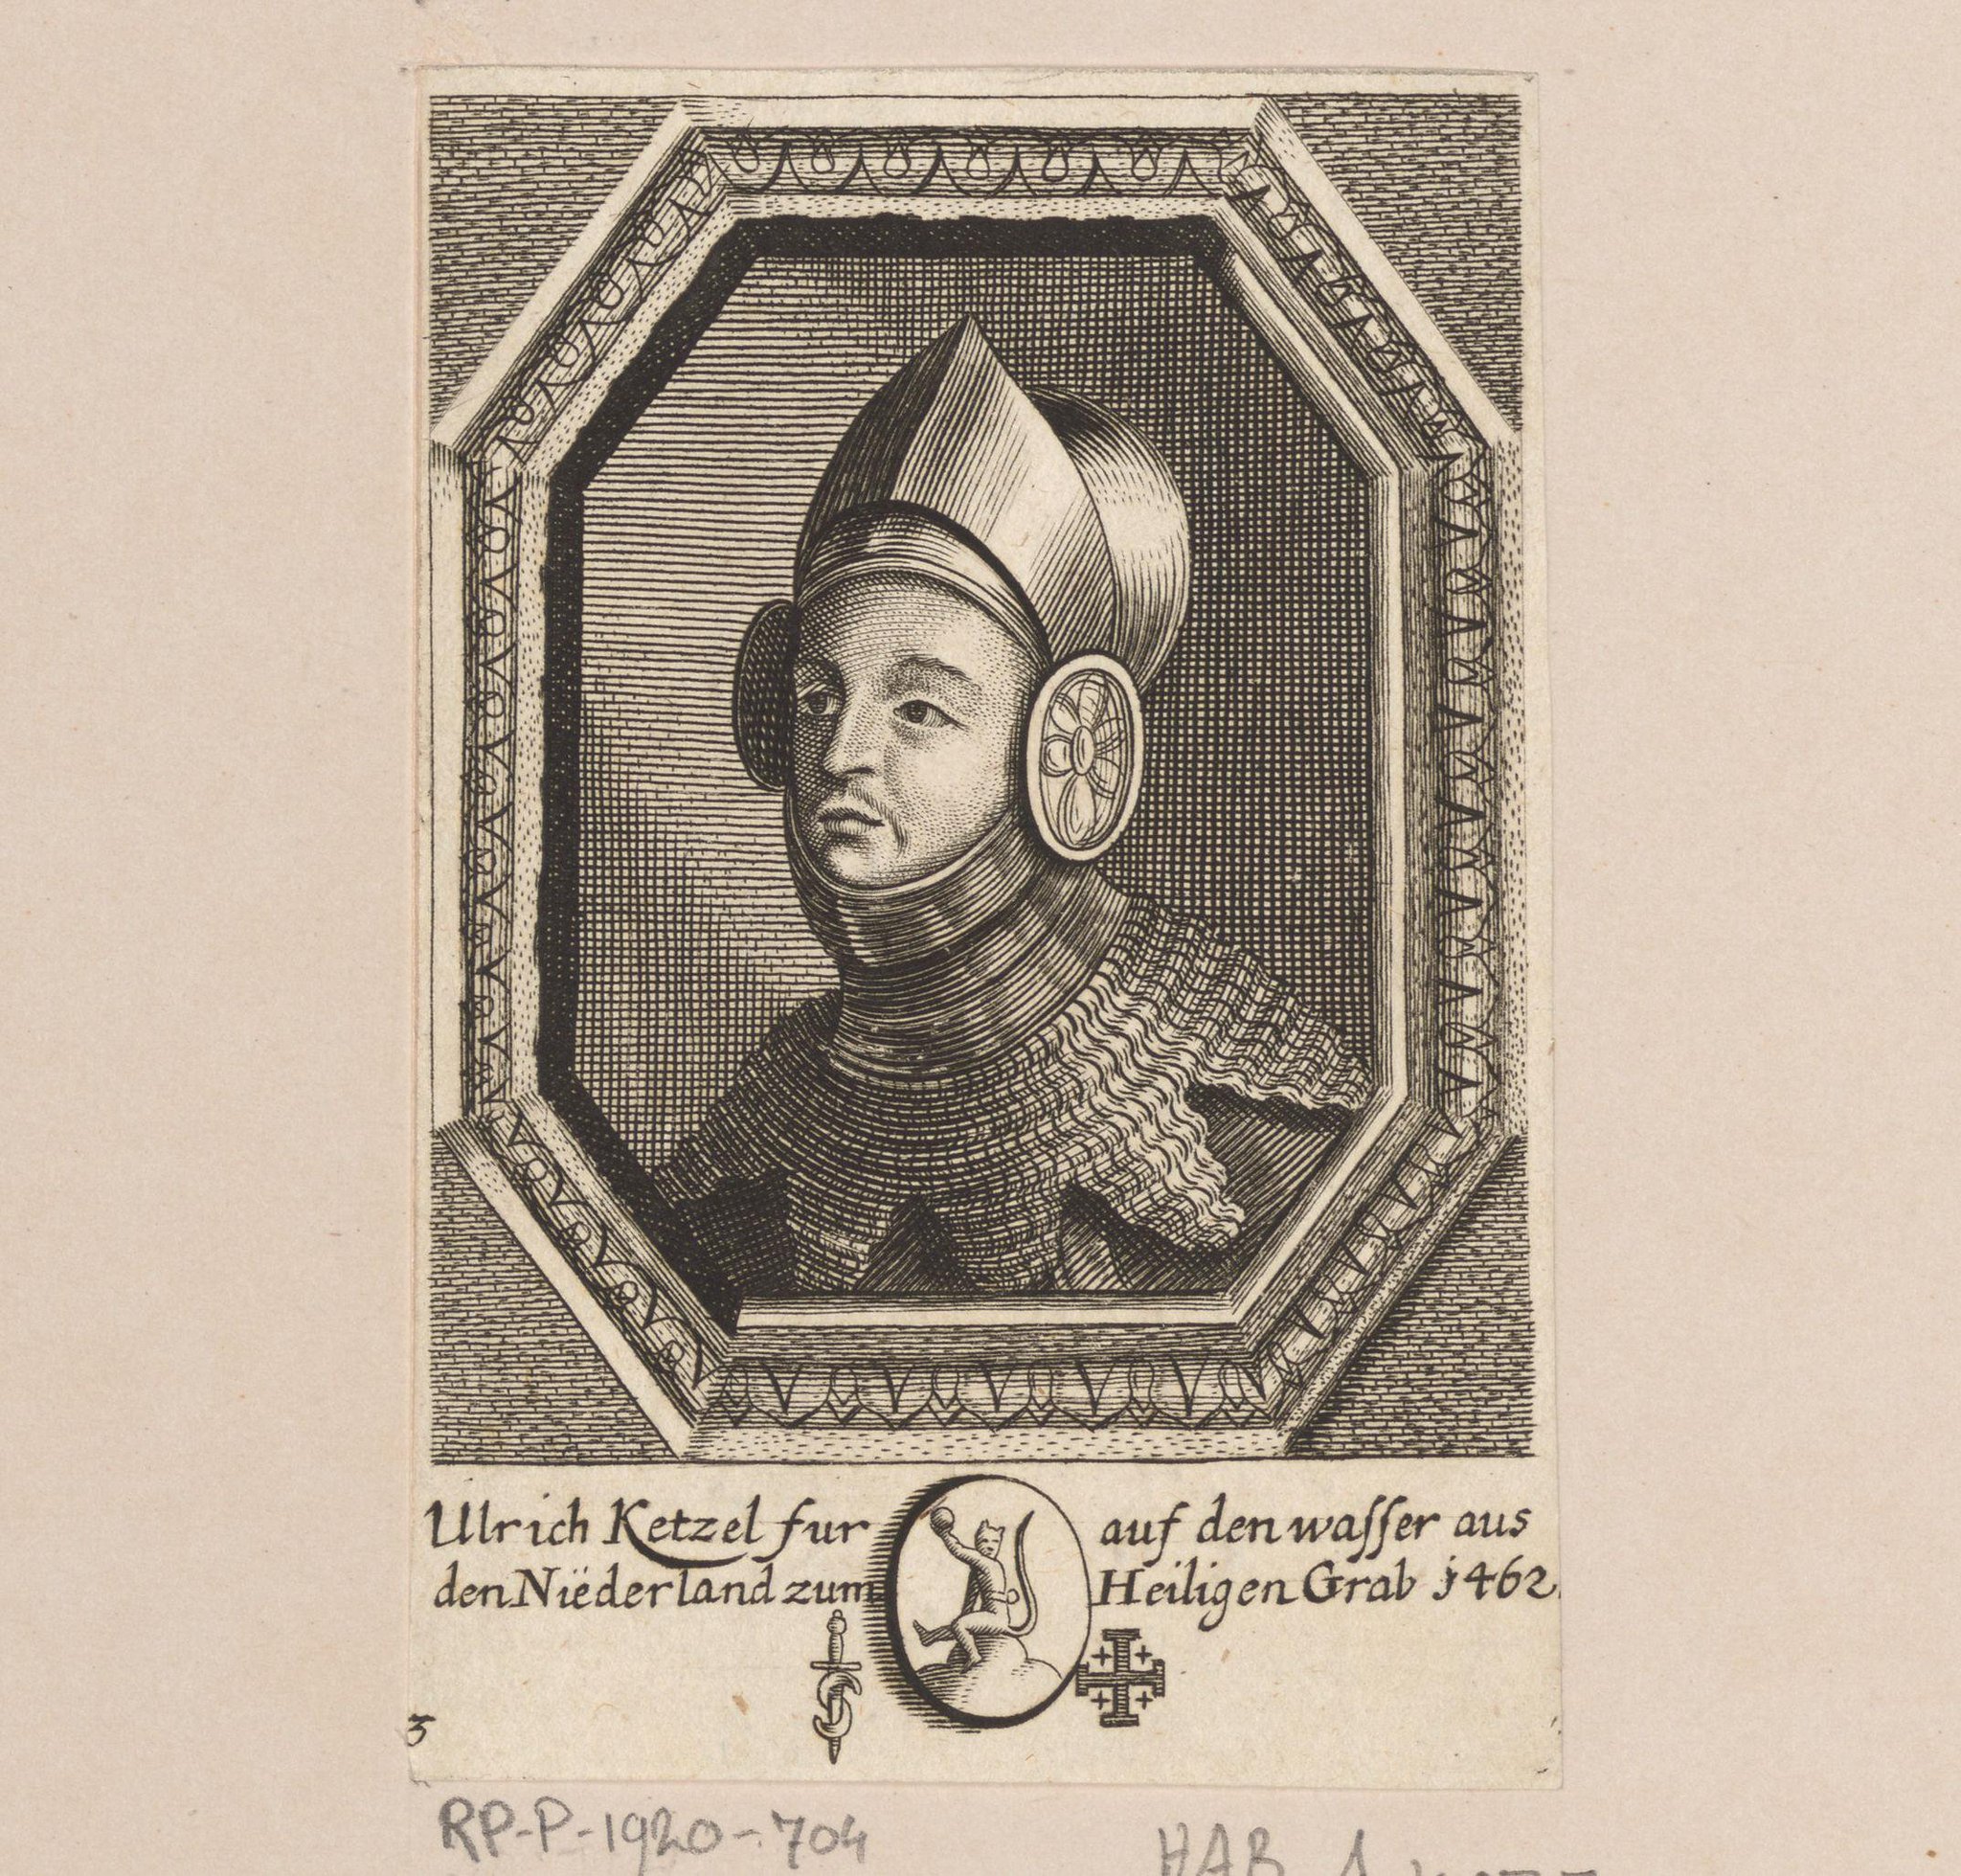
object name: print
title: Portret van Ullrich Ketzel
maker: Anonymous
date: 1600-1699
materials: paper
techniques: engraving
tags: helmet, historical persons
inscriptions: collector's mark: Lugt 2228